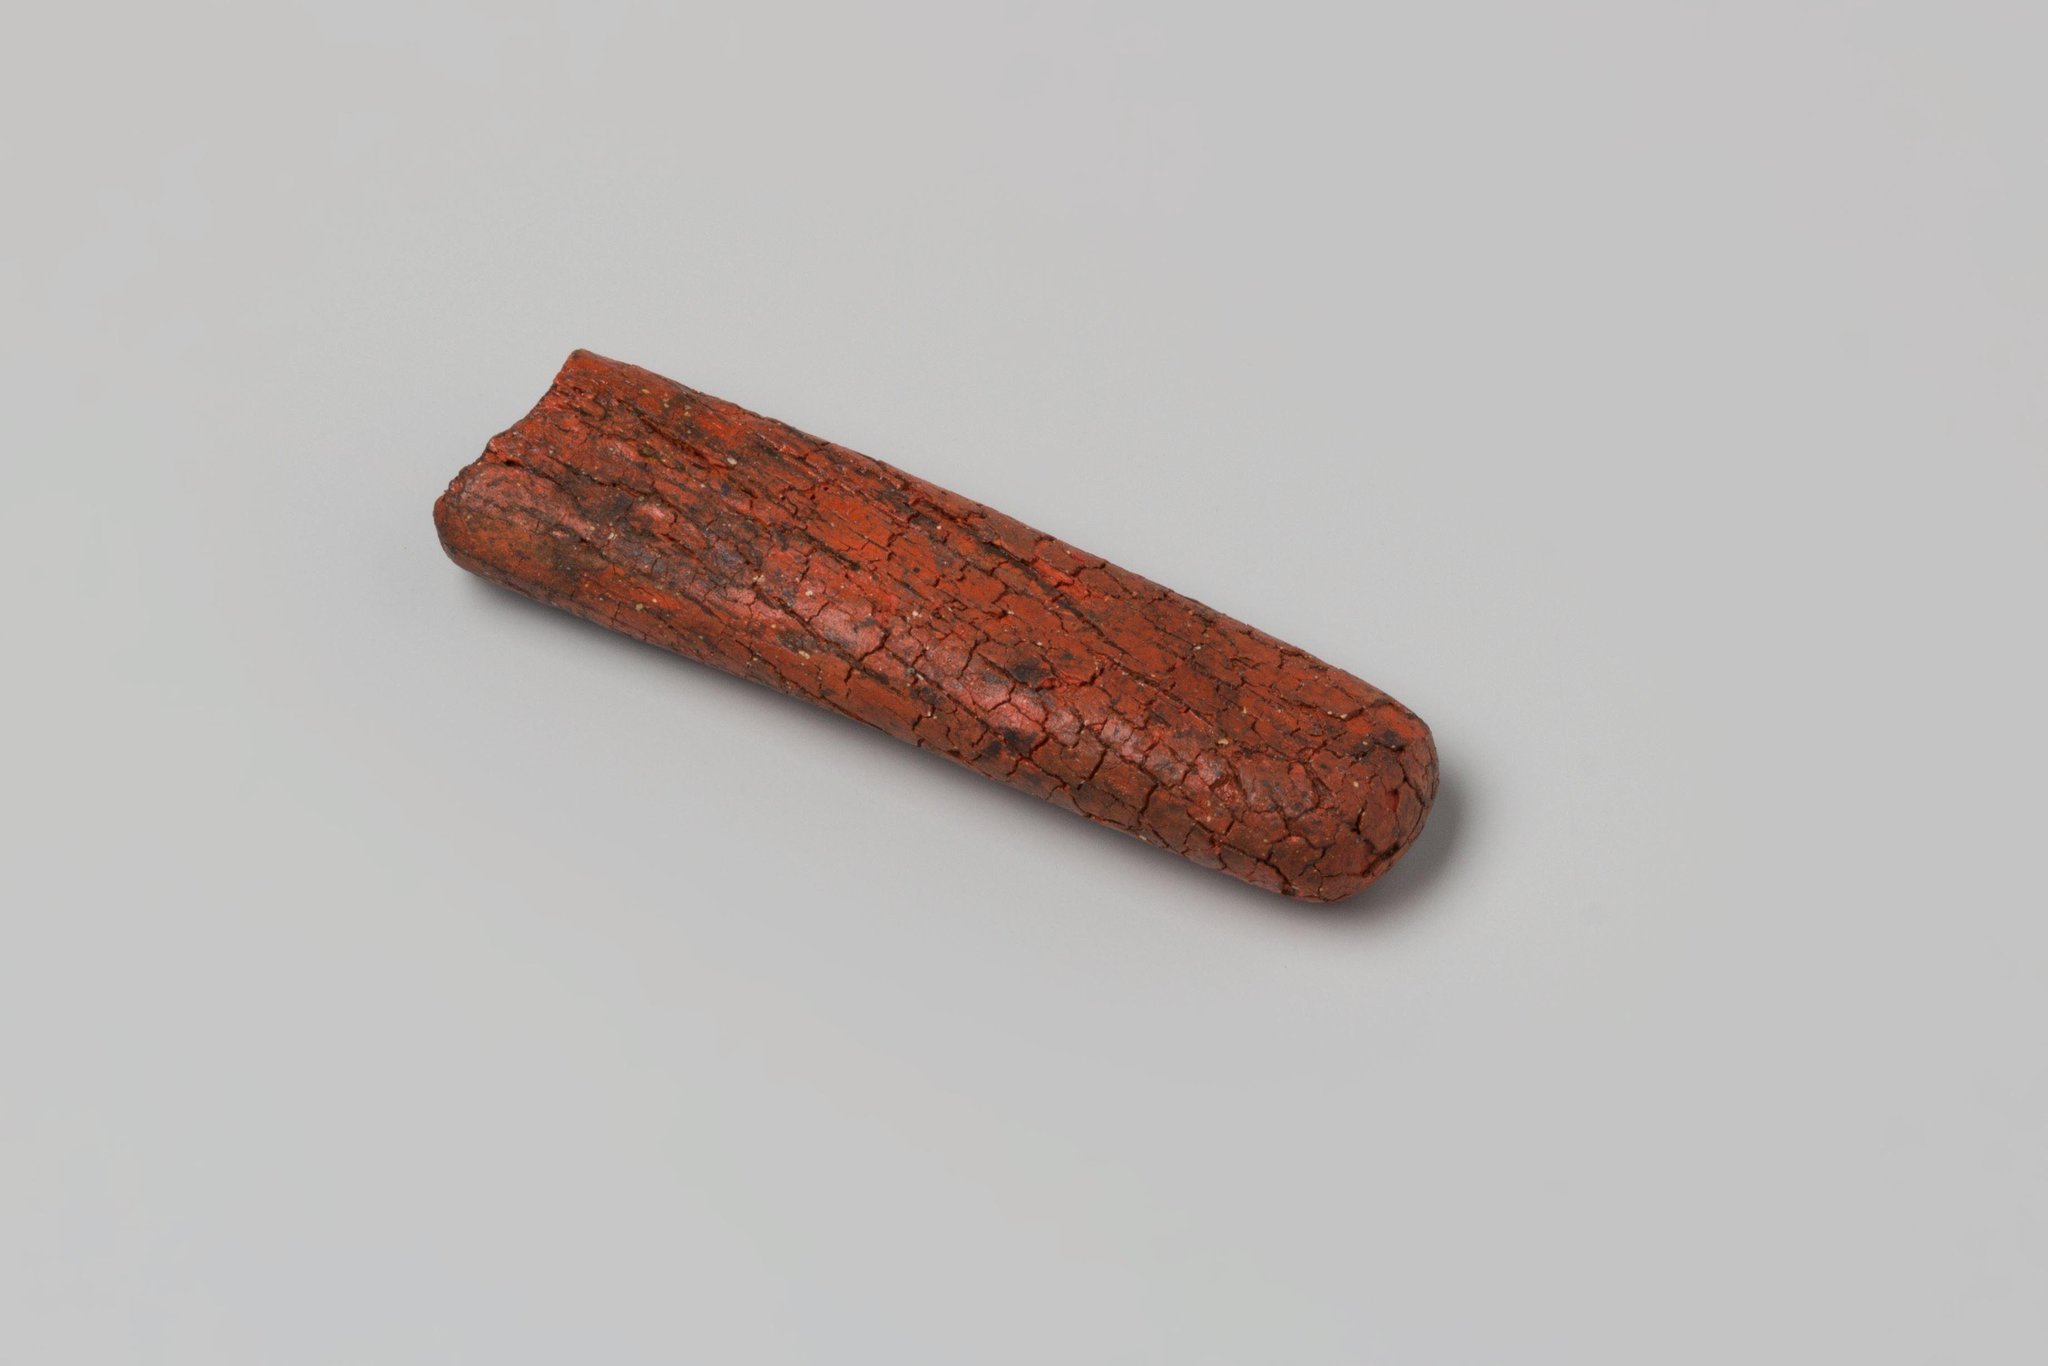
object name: sealing wax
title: Staafje zegellak uit het wrak van de Oost-Indiëvaarder Hollandia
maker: Anonymous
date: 1700-1743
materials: wax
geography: netherlands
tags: verenigde oostindische compagnie, hollandia (schip), annet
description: Marking and proving, sealing wax, red; fragm, id. NG 1975-50H446, one rounded end.